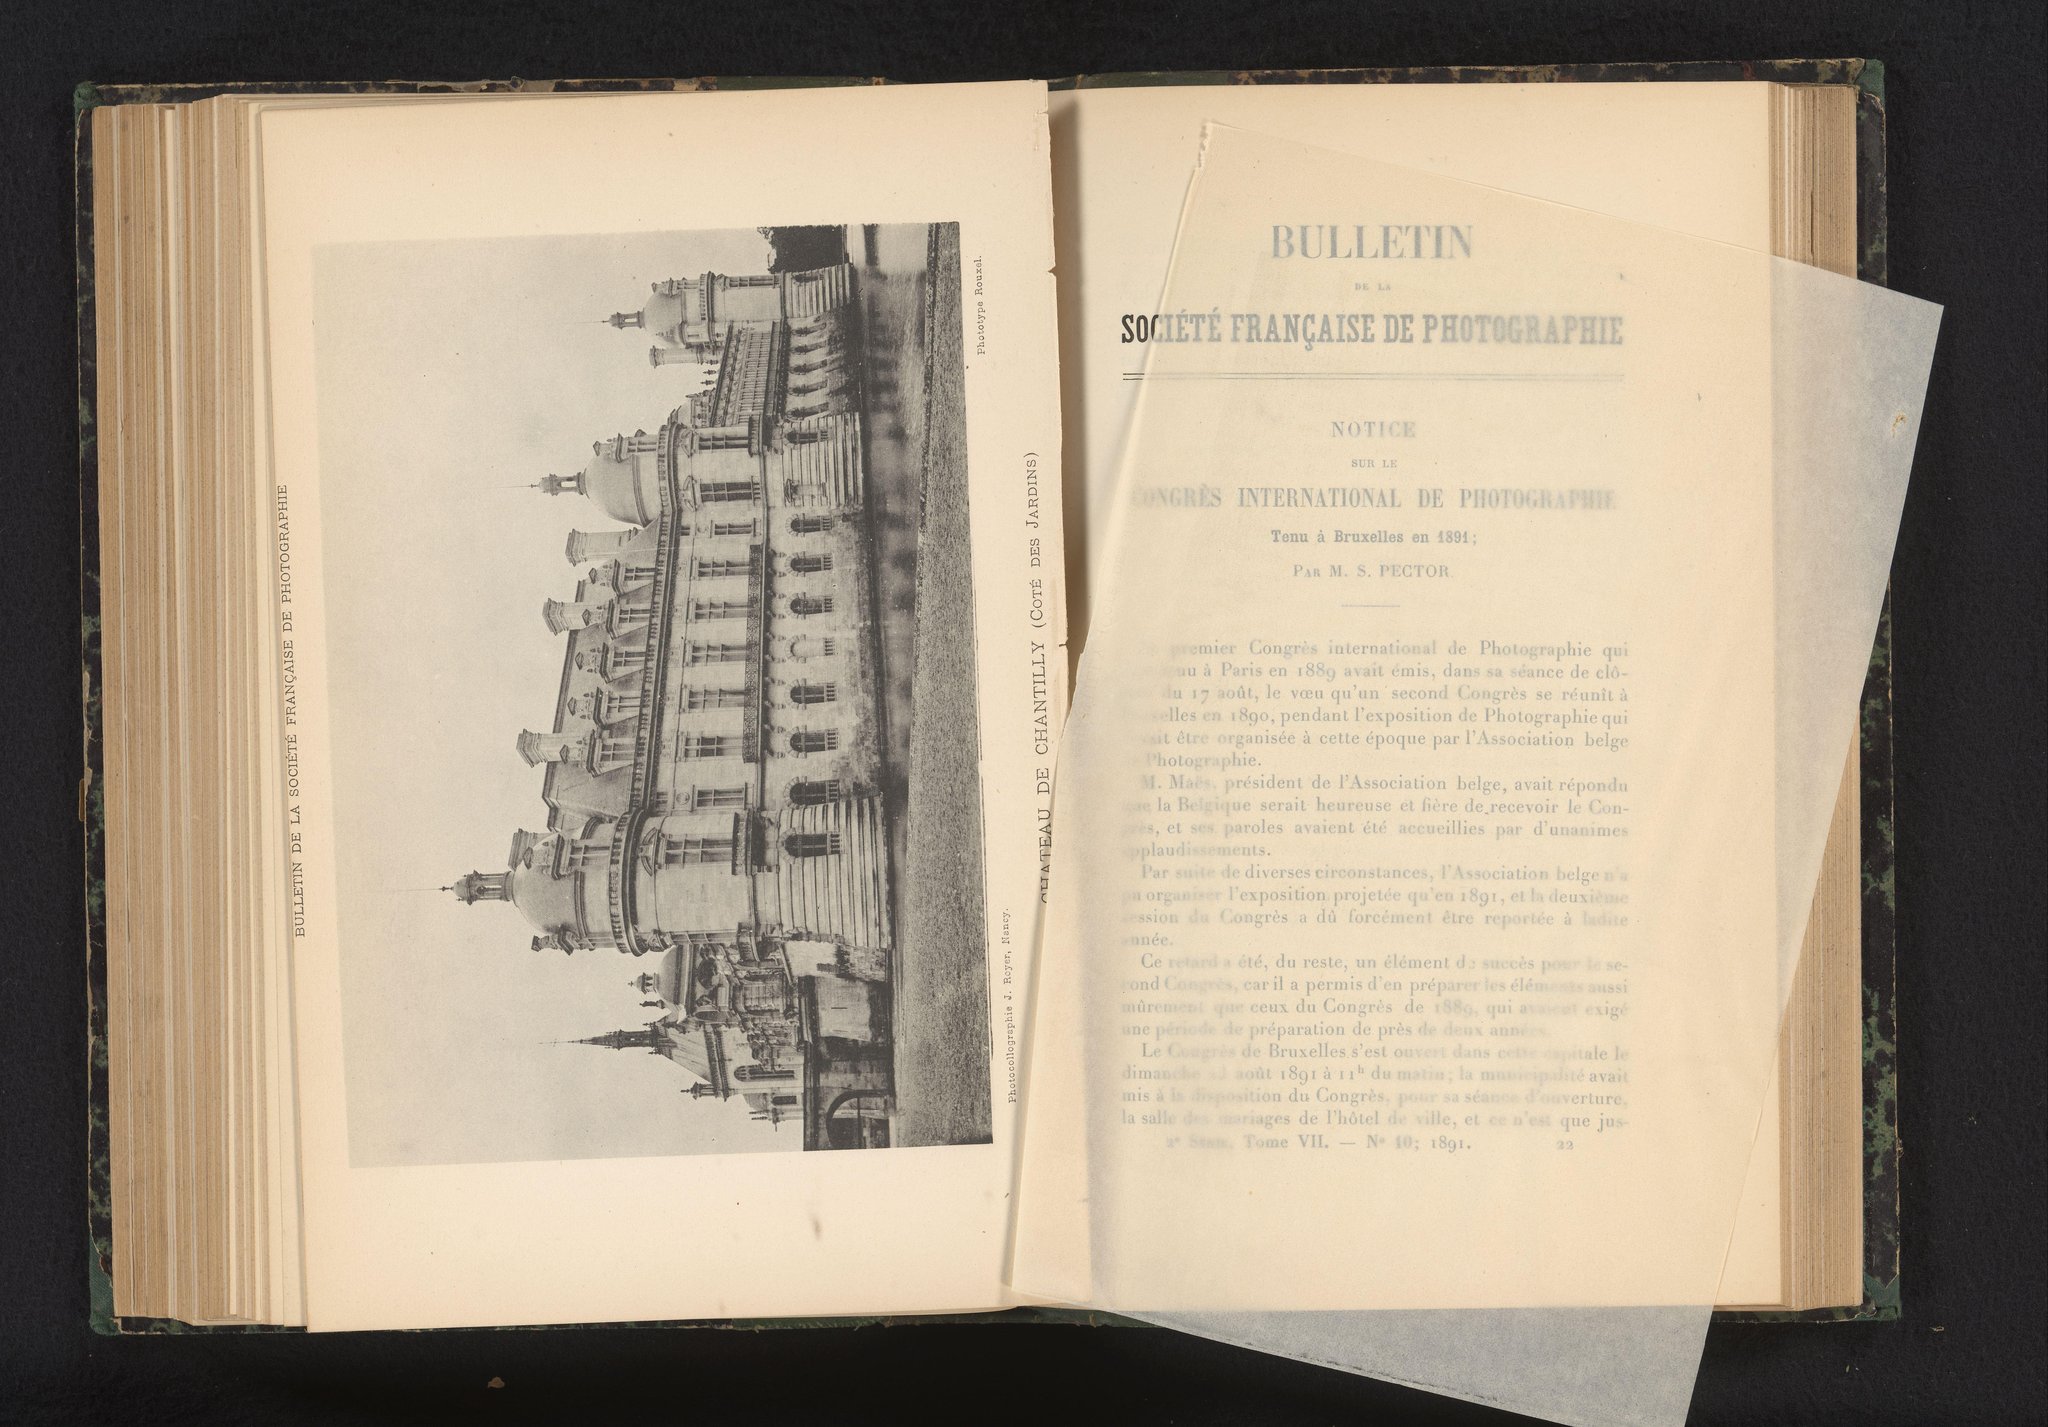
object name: photomechanical print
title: Chateau de Chantilly (Coté du Champ de Courses)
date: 1886-1891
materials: paper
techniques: photograph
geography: nancy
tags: castle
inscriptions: inscription: ‘(Château Moderne) (Château Ancien)’